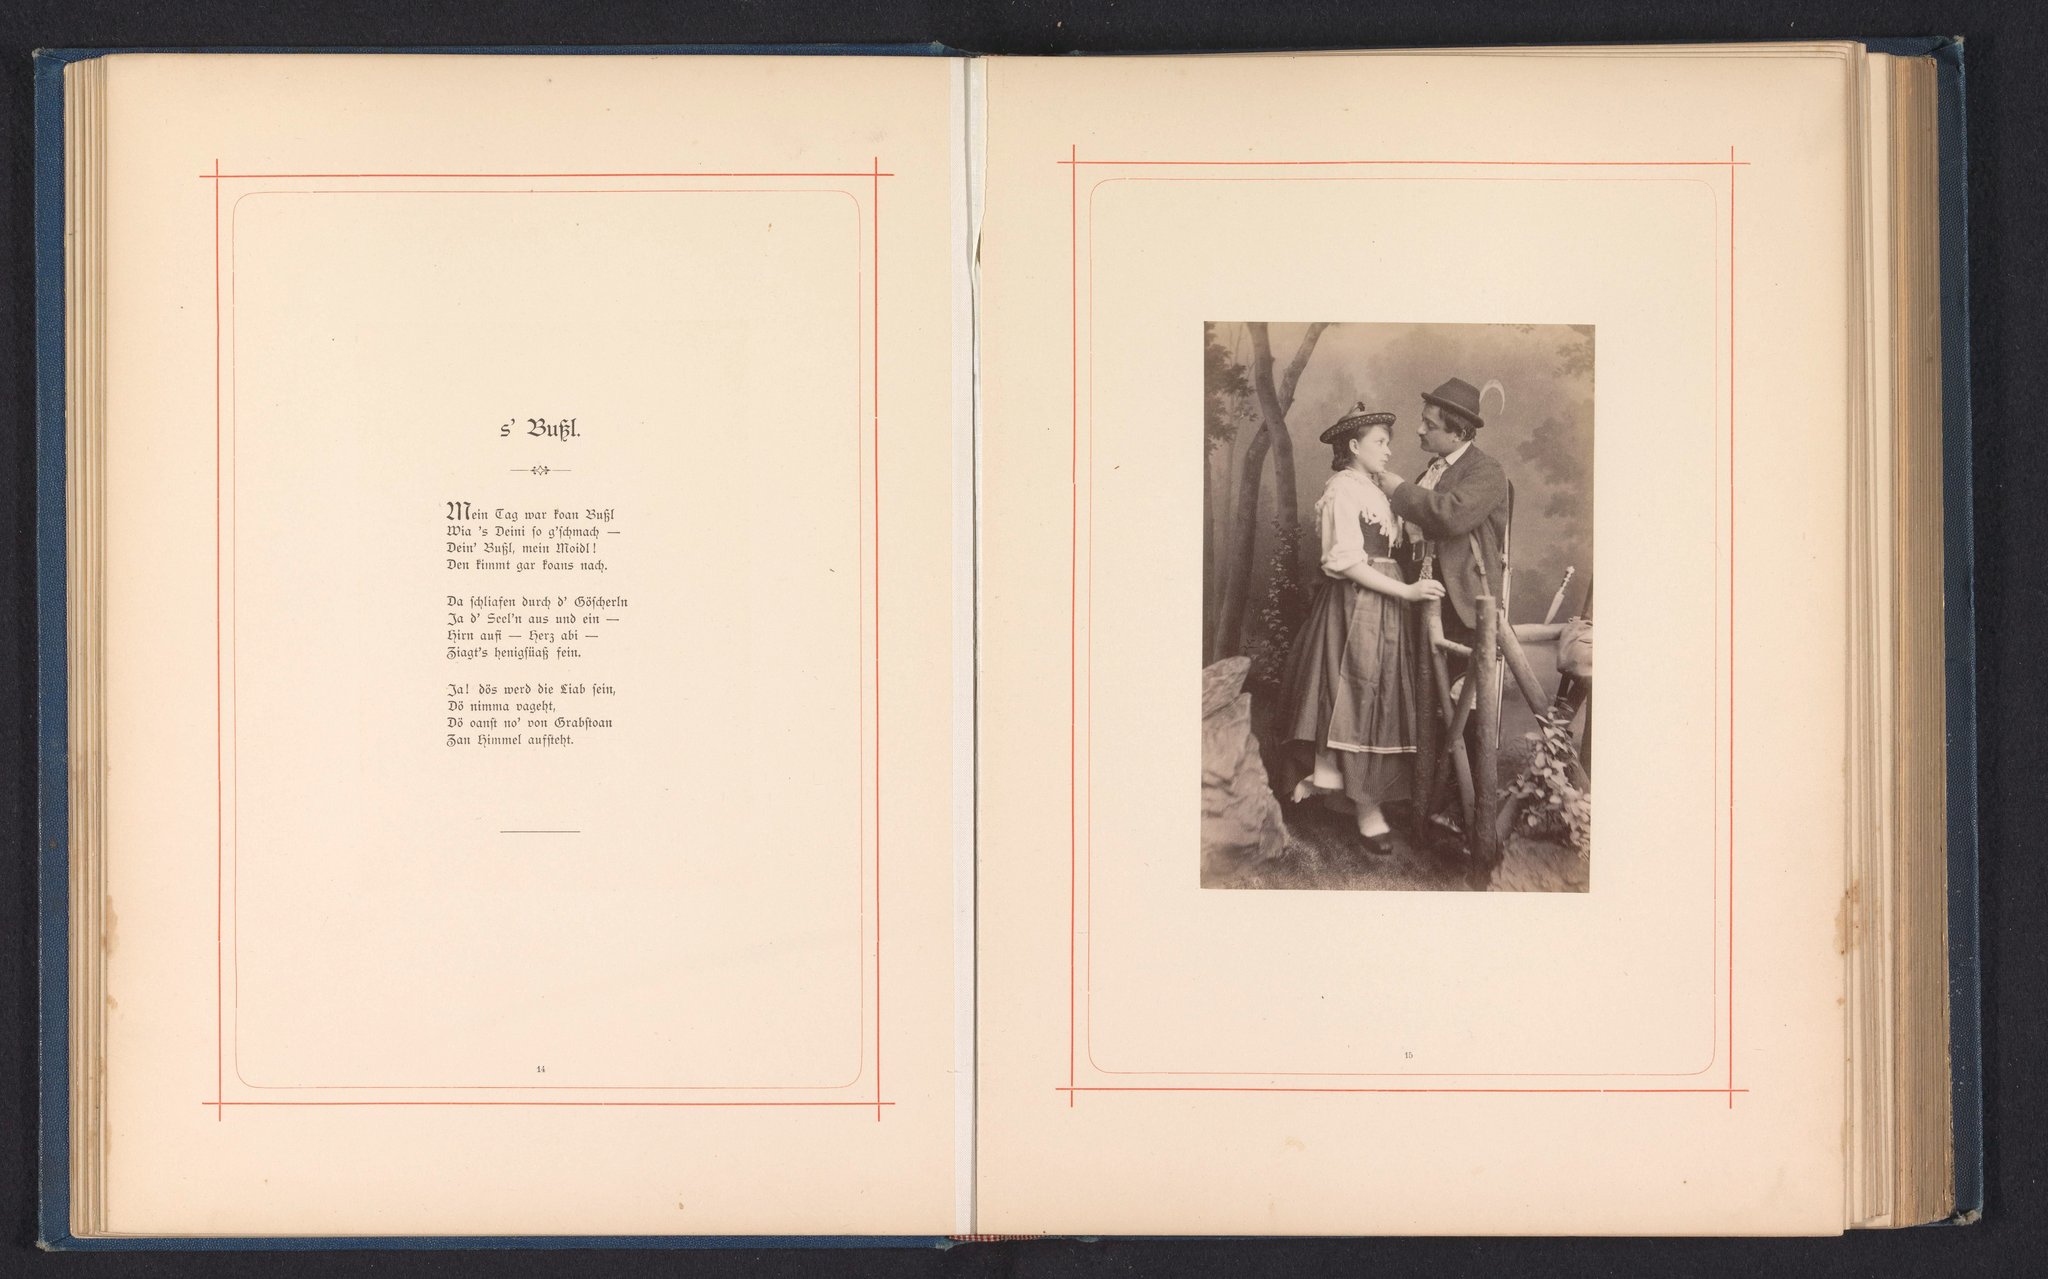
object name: photograph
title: Liefkozend stel in klederdracht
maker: max balde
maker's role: fotograaf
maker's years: 1844-1900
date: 1877-1882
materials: photographic support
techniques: albumen print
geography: salzburg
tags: studio ~ photographer, folk costume, regional costume, (lovers) caressing each other